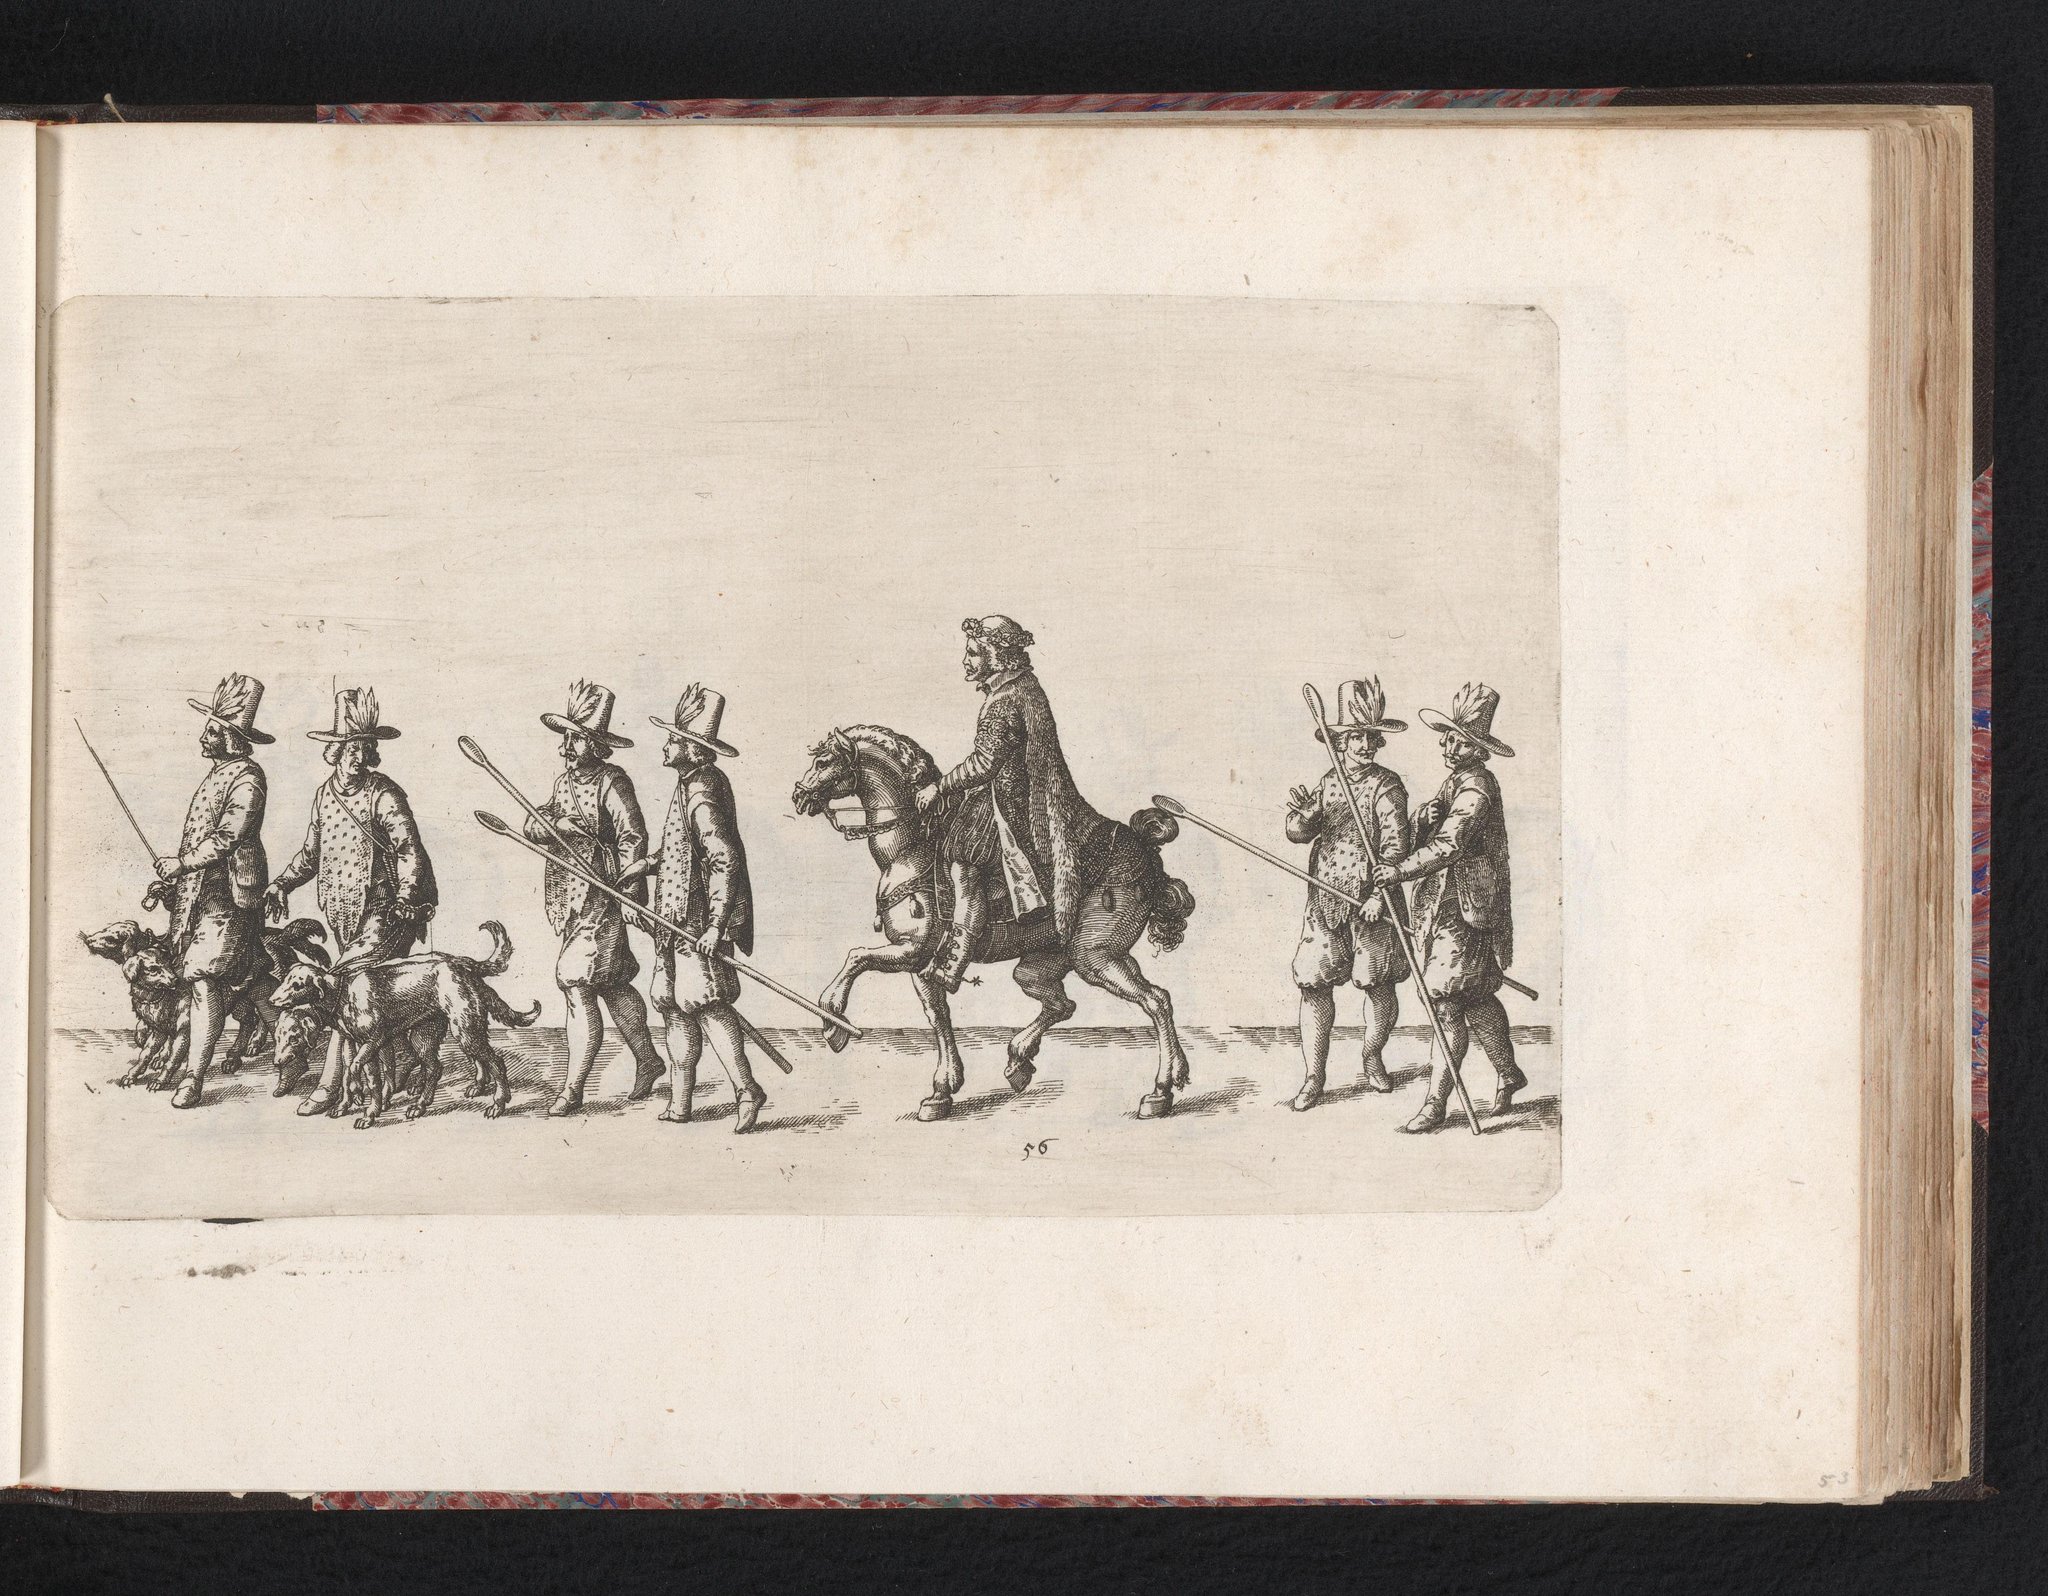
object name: print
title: Aigentliche wahrhaffte Delineation unnd Abbildung aller fürstlichen Auffzüg und Rütterspilen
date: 1618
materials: paper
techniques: etching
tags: horn, trumpet, cornet, trombone, tuba - cc - out of doors, performance in the open air (pleasure fair)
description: Genummerd: 55. Deze prent maakt deel uit van een album.